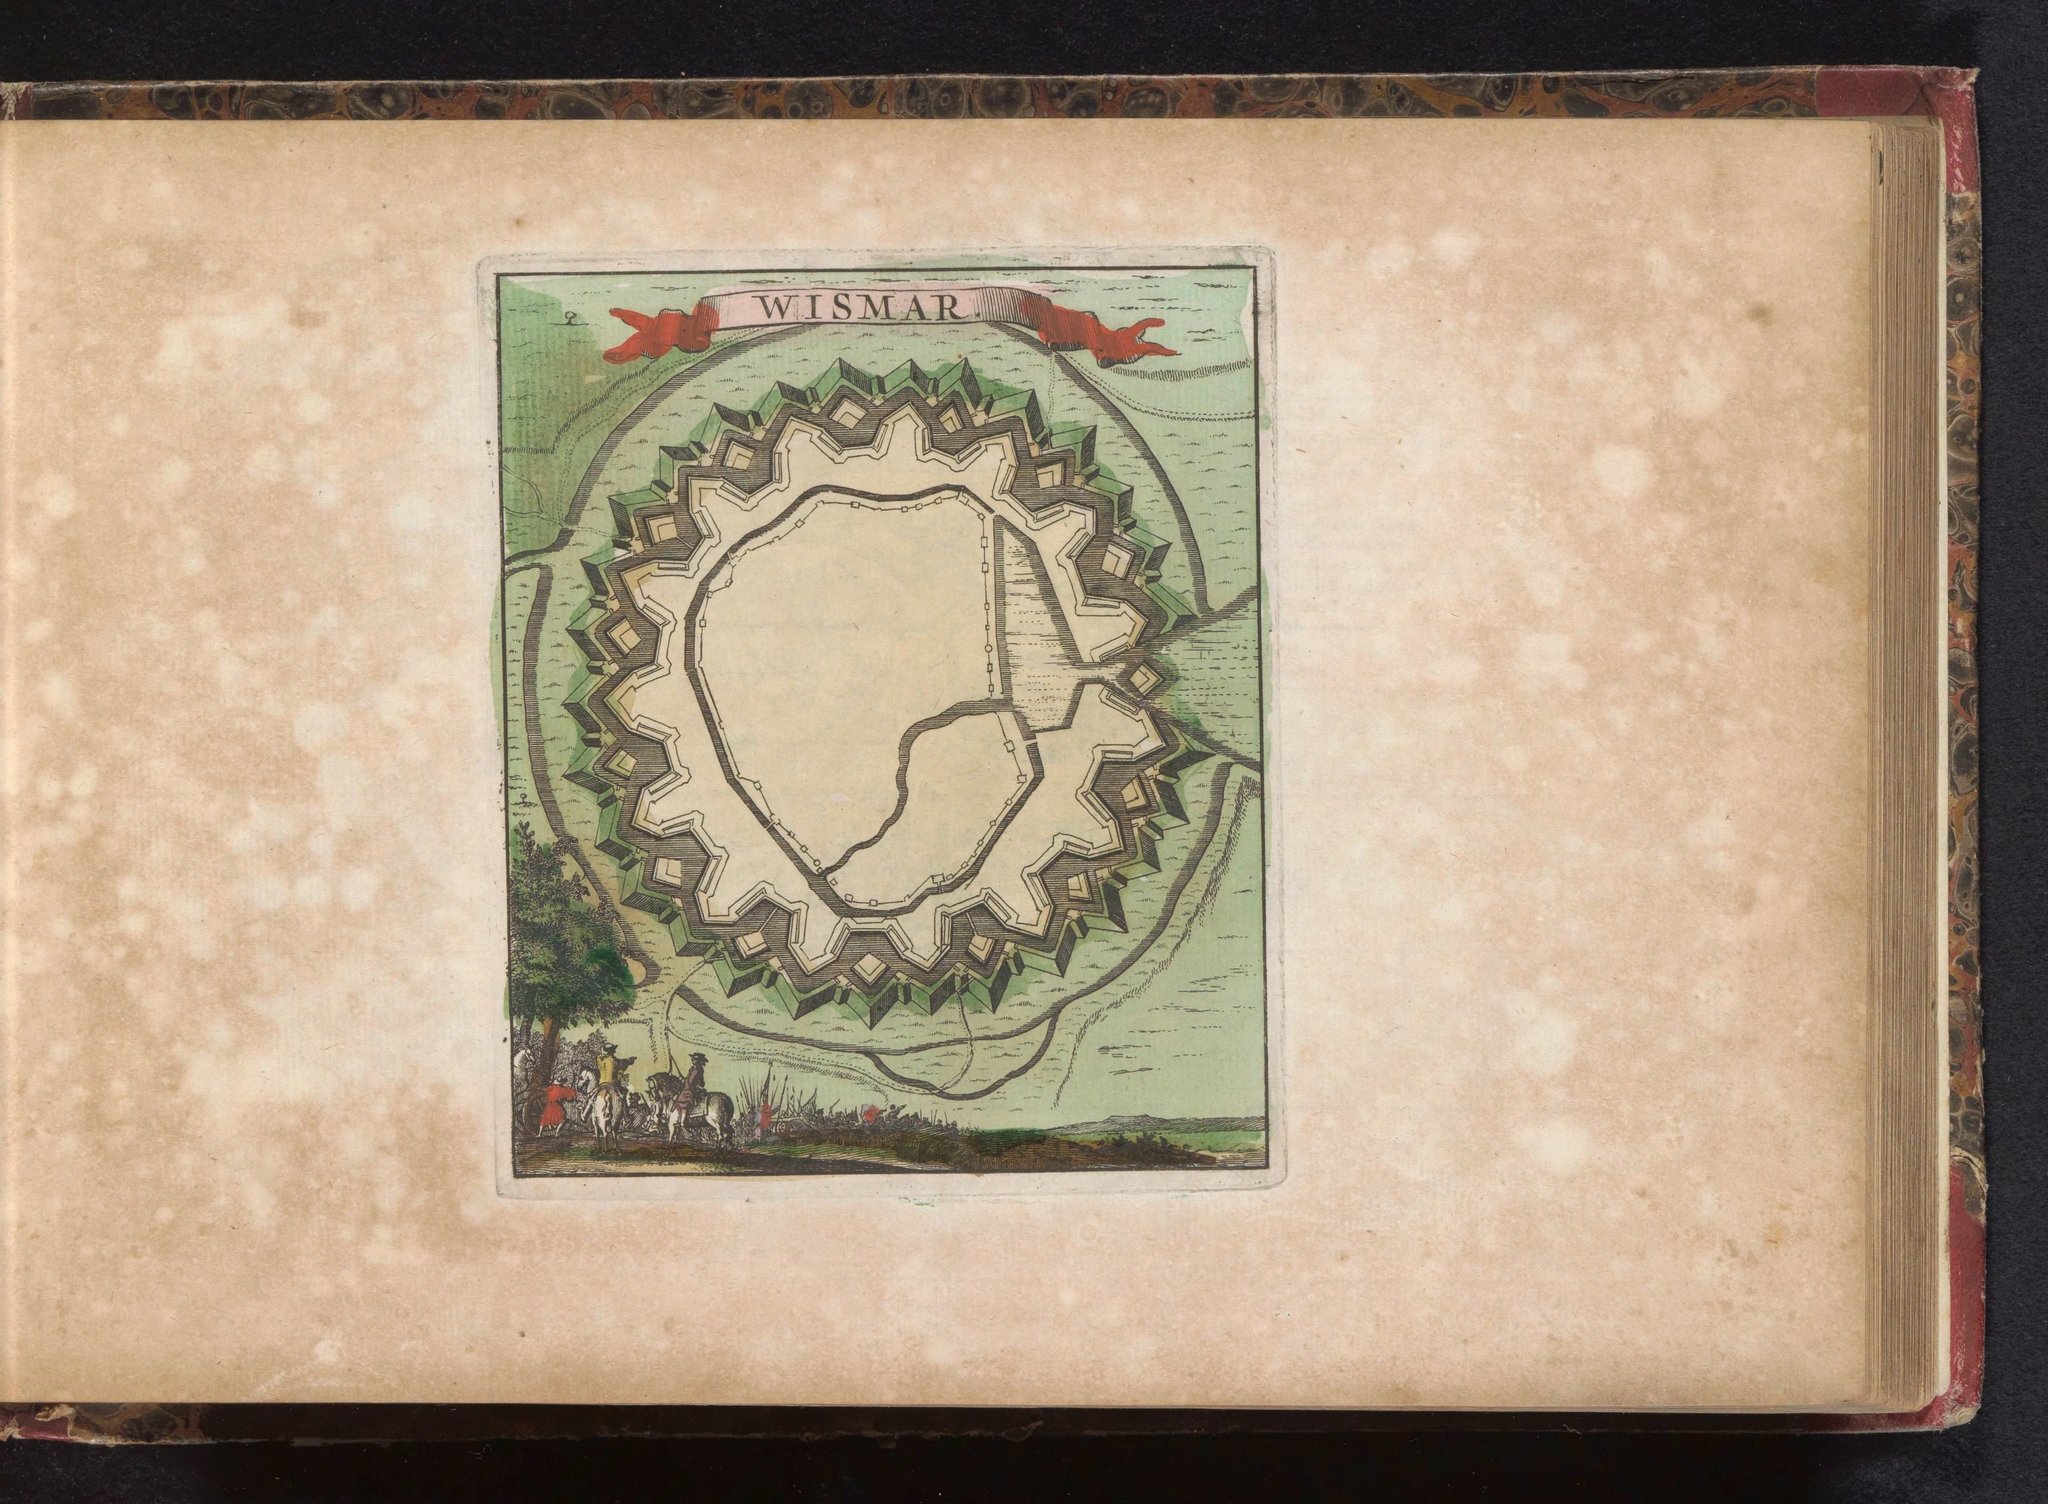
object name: map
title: Plattegrond van Wismar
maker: Anonymous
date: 1735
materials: paper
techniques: engraving, etching, hand coloring, lacquer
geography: northern netherlands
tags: fortress, maps of cities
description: Plattegrond van de versterkingen om de stad Wismar. Linksonder een soldaat die op een tablet schrijft. Onderdeel van een atlas met 223 kaarten van landen en steden en oorlogstaferelen in Europa in de periode ca. 1690-1735.